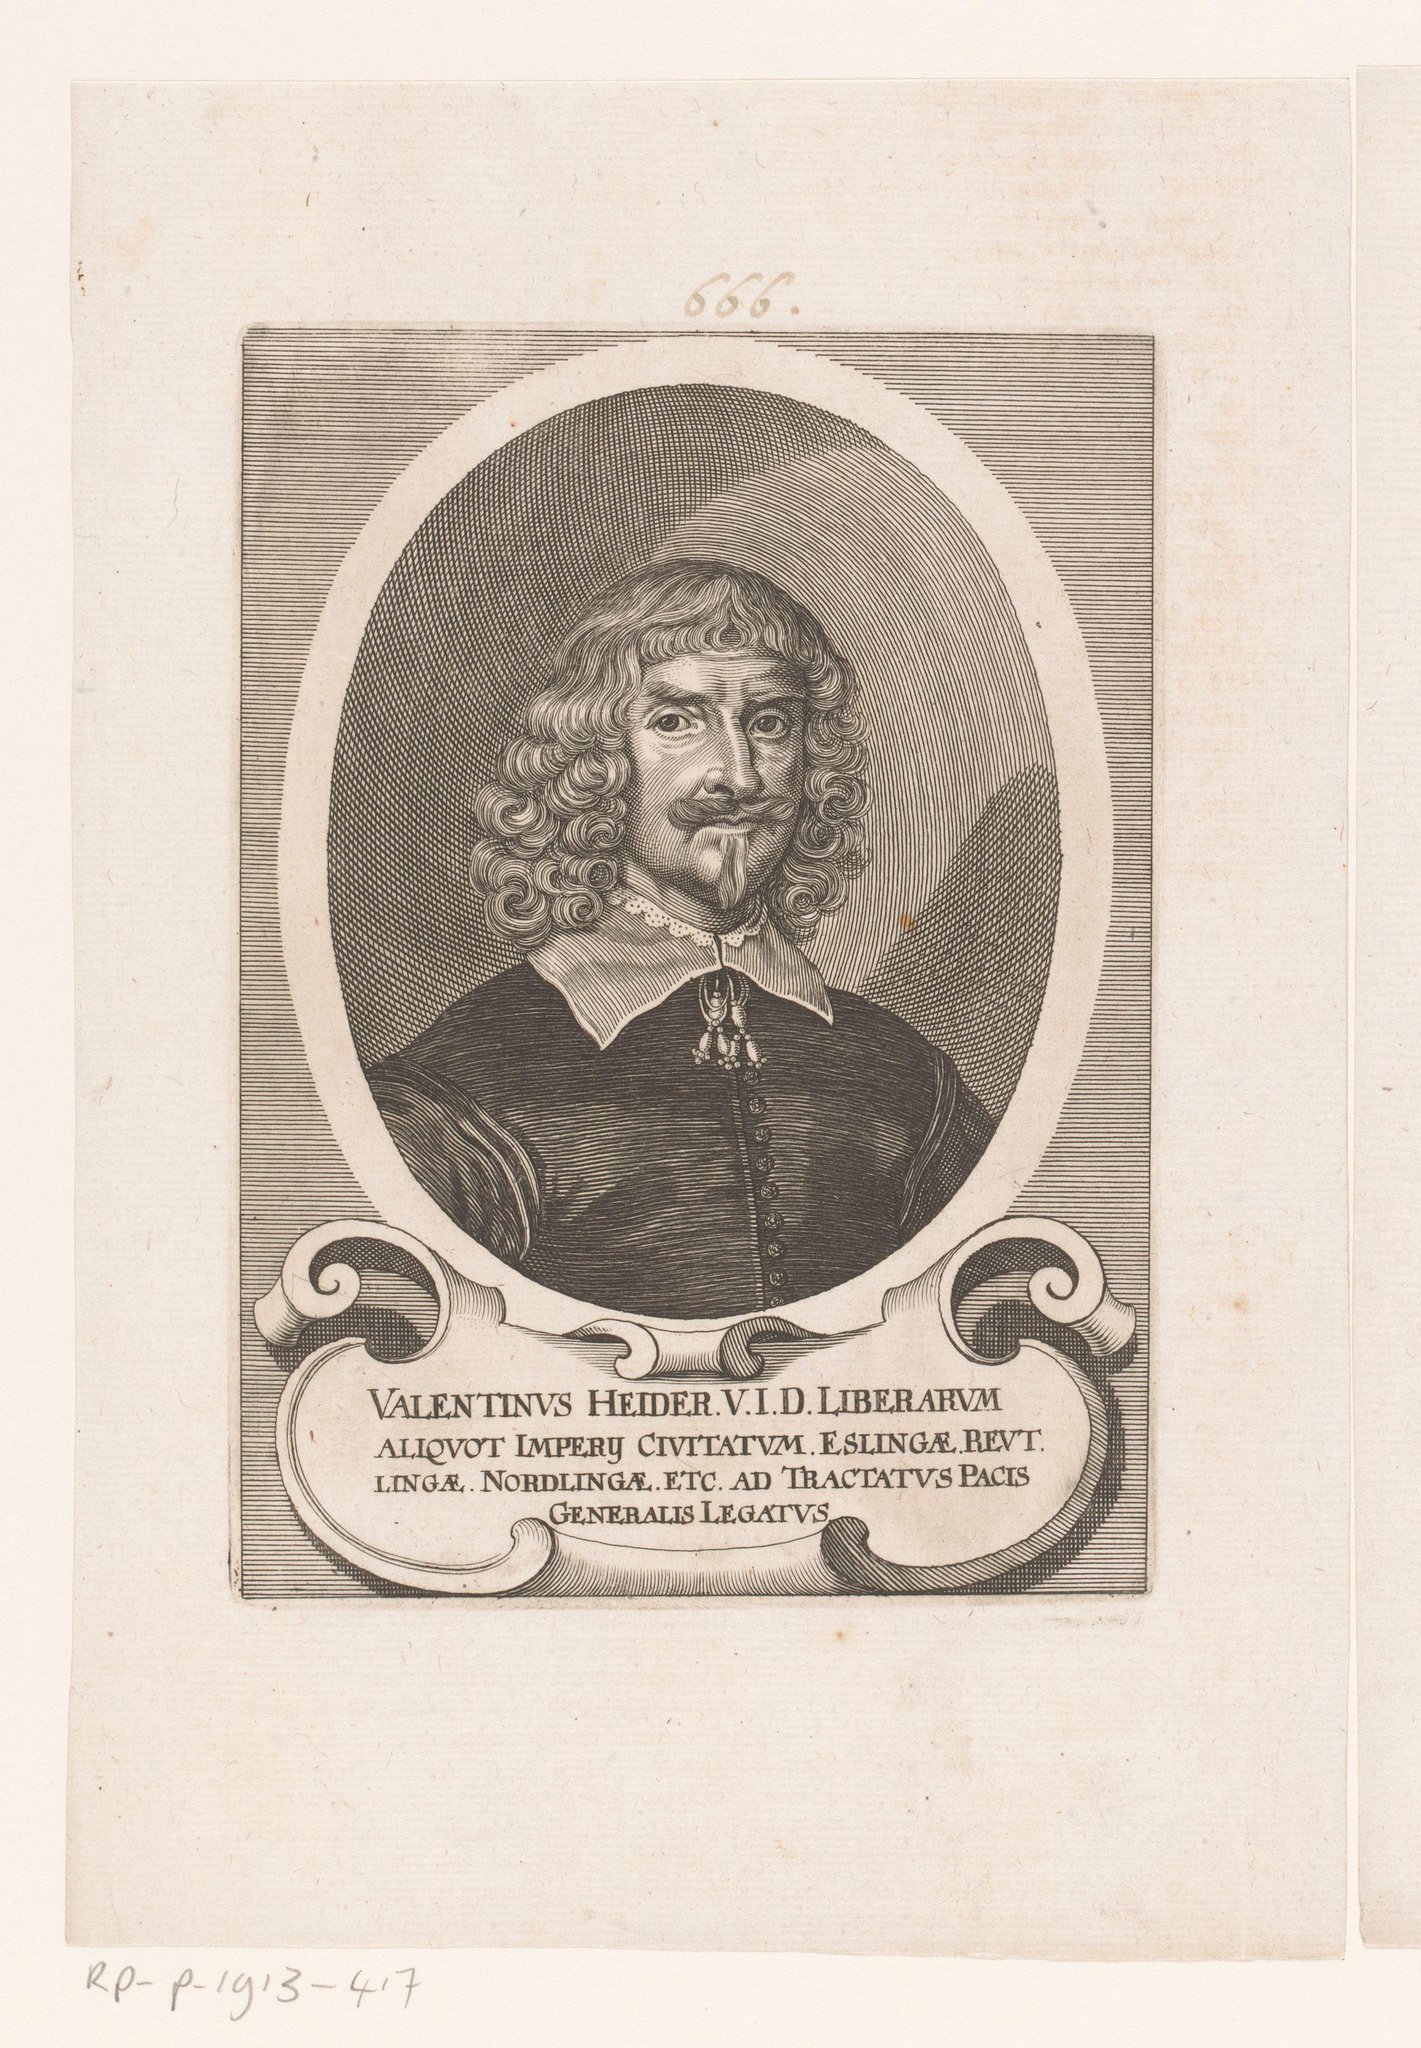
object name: book illustration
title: Portret van Valentinus Heider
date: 1652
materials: paper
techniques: engraving, etching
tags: historical persons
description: Illustratie in: J.G. Schleder. Theatrum Europaeum. Dl. 6. Frankfurt a.M., Merian, 1652. P. 666.